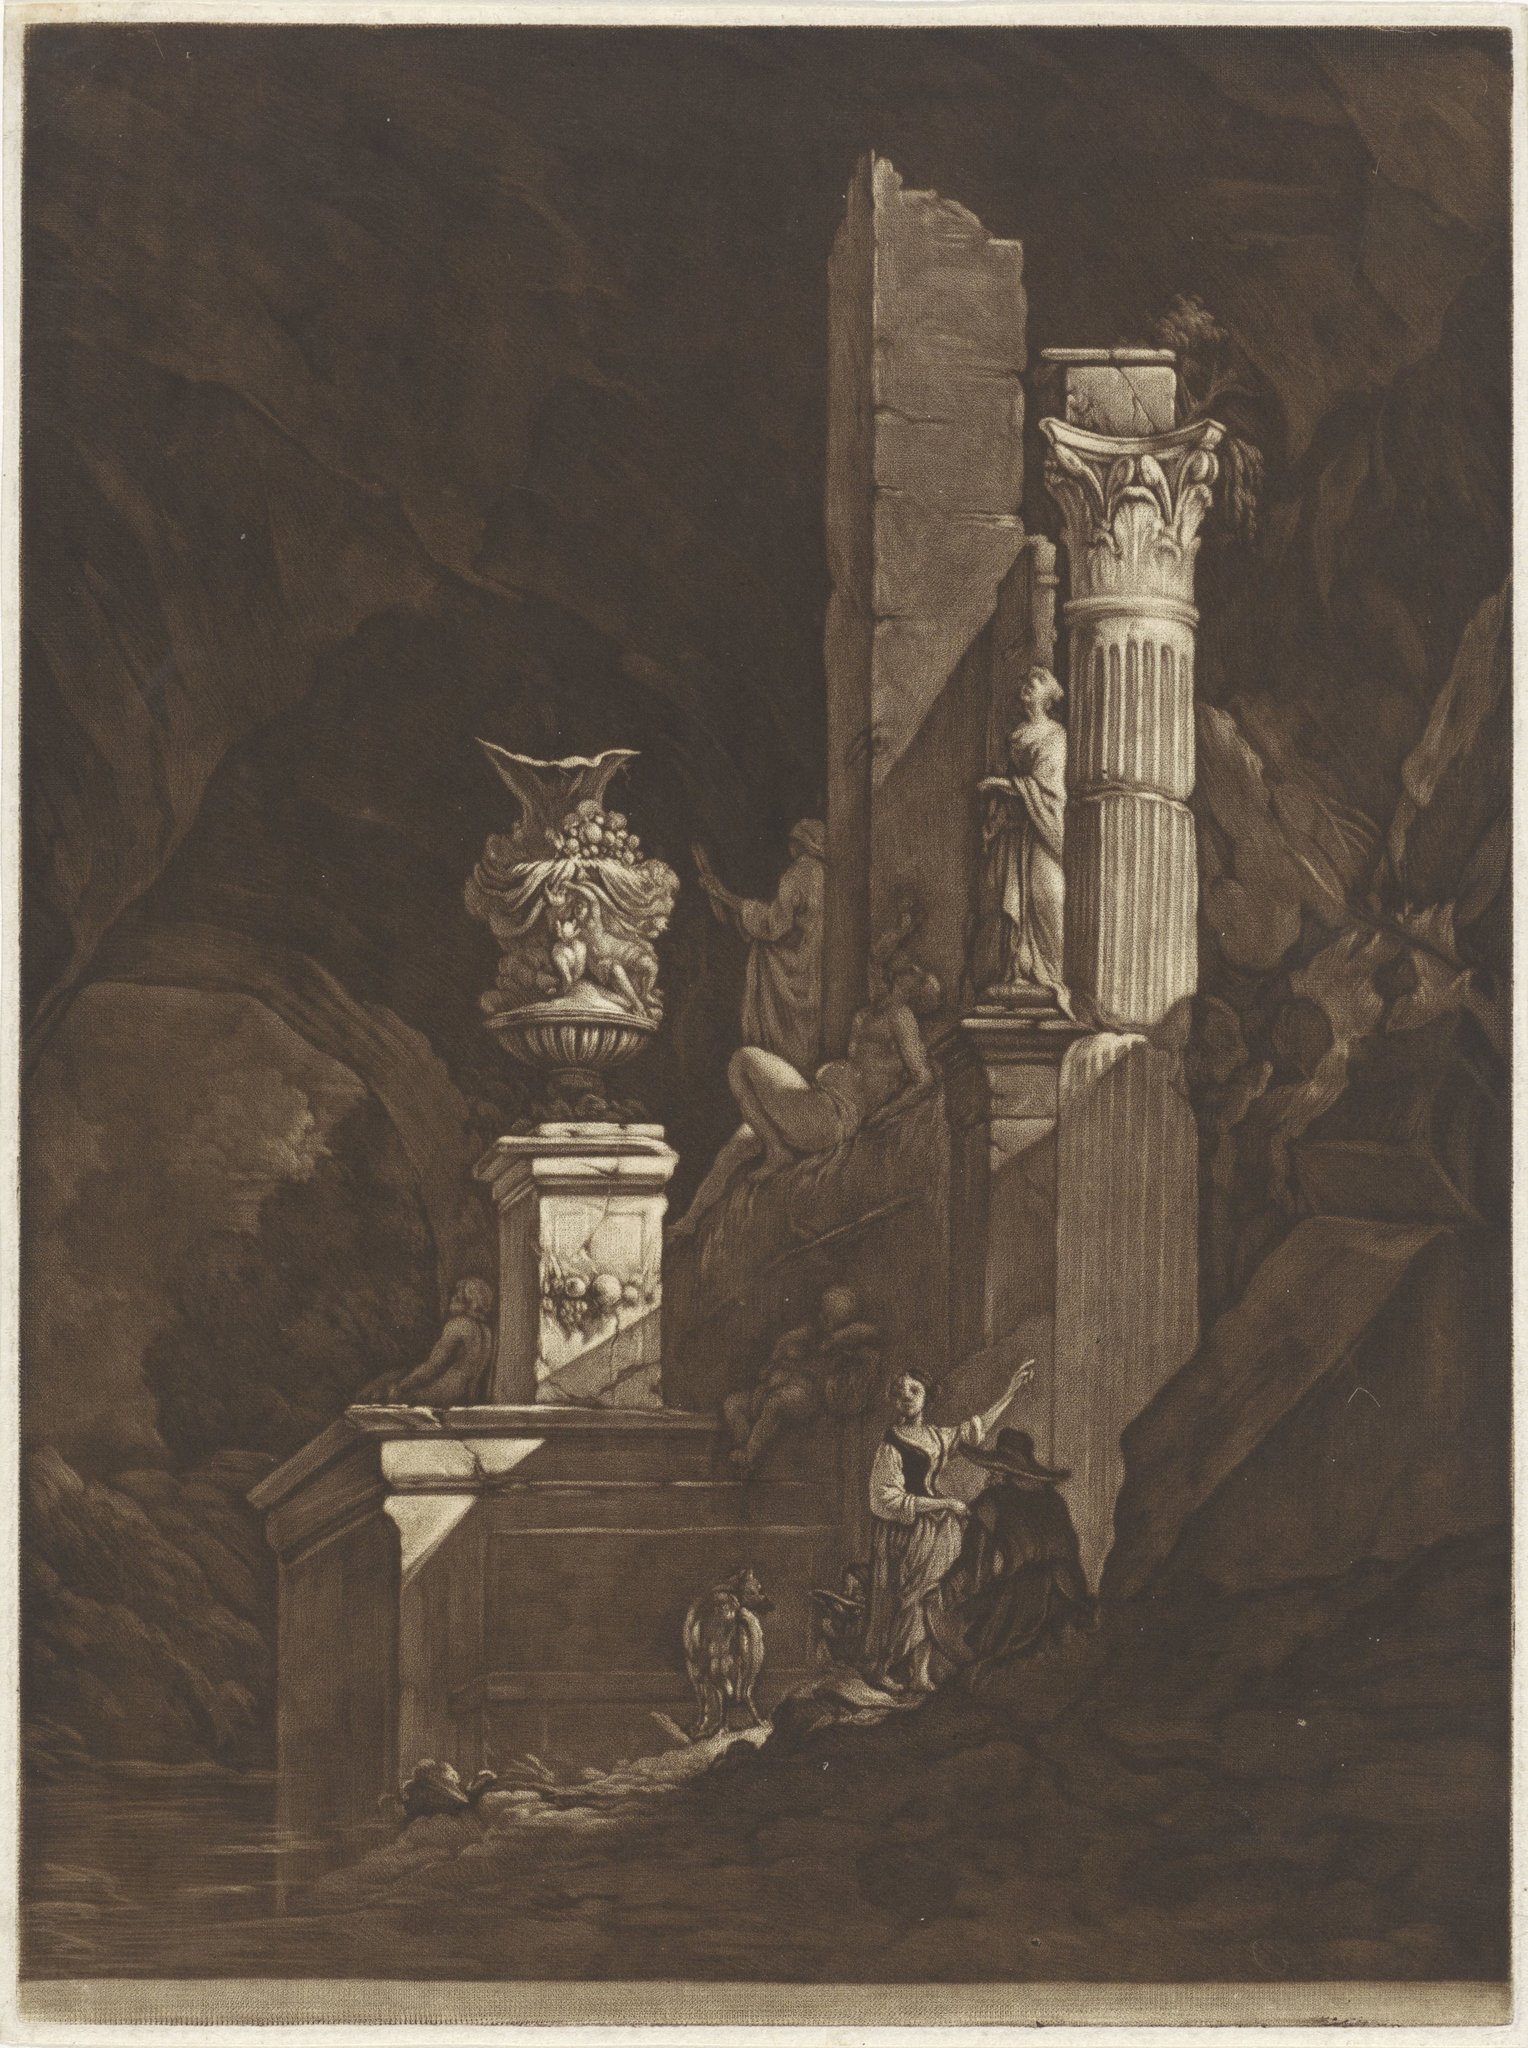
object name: print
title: Klassieke ruïnes in een grot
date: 1740-1774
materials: paper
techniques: mezzotint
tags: herding, herdsman, herdswoman, shepherd, shepherdess, cowherd, etc., ruin of a building ~ architecture, cave, grotto, dog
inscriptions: collector's mark: Lugt 2228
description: Twee herders en een herderin met een hond bevinden zich in een grot bij klassieke ruïnes.